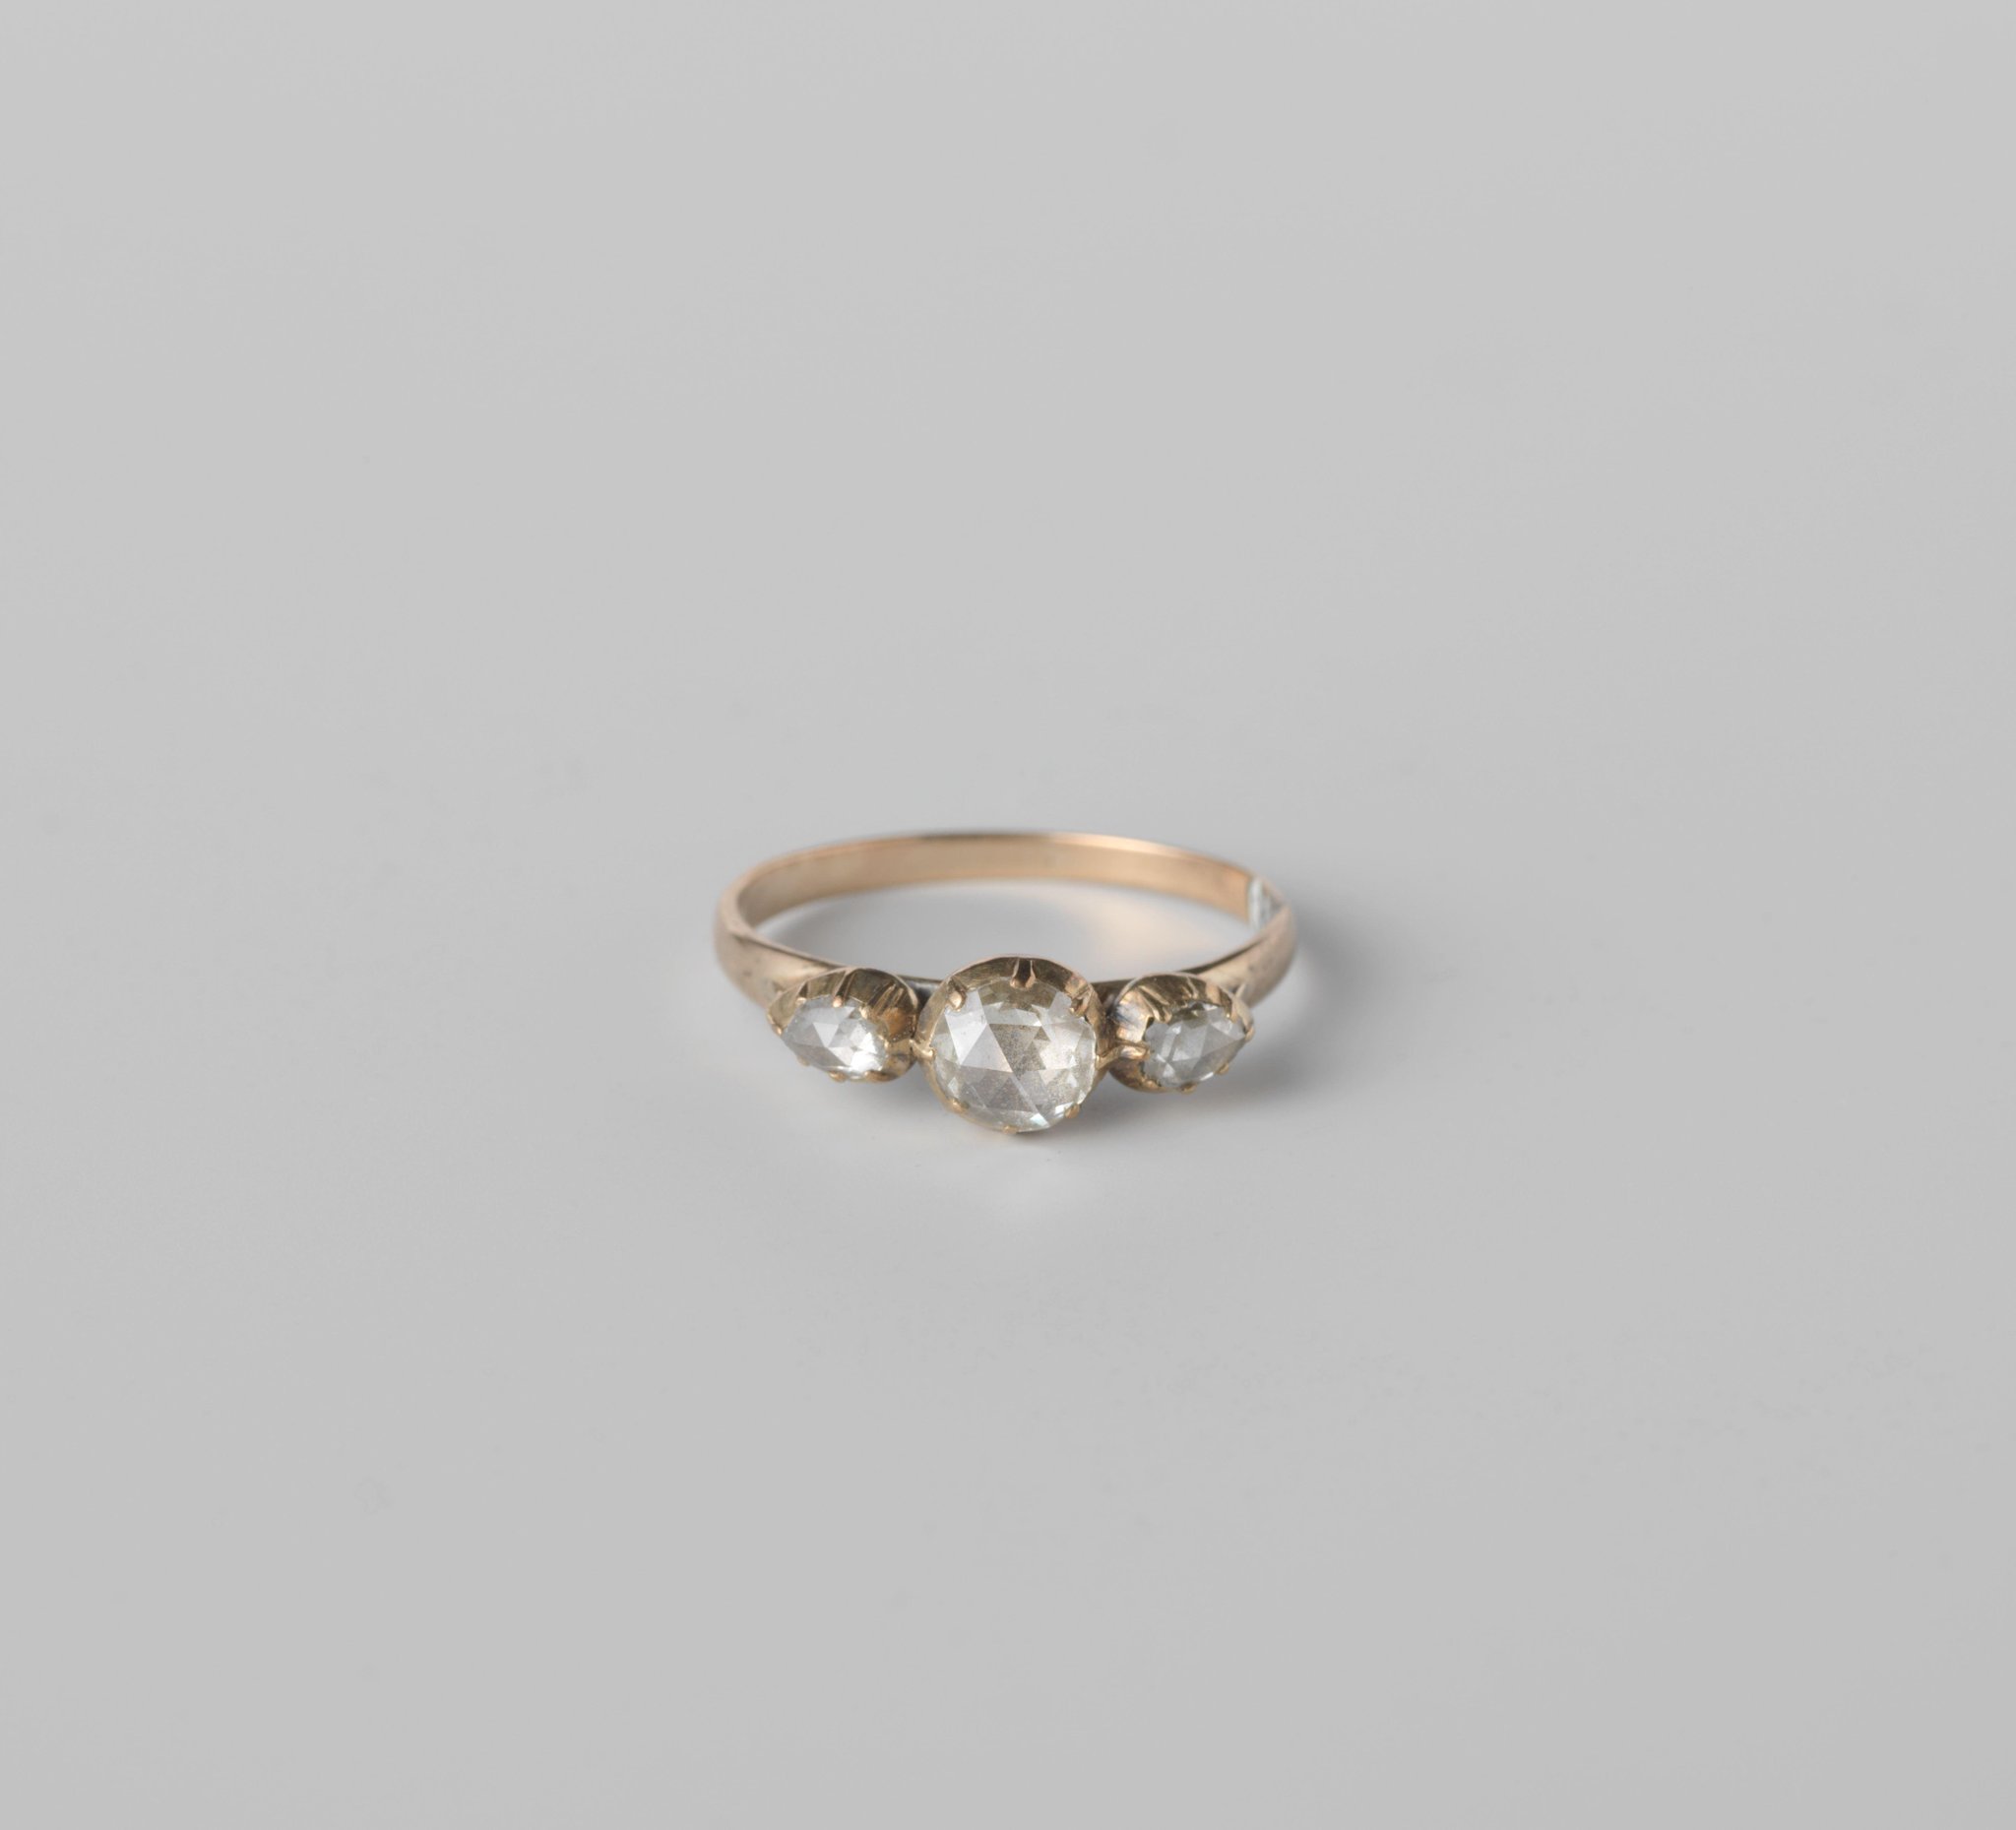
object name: ring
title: Ring met diamanten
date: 1800-1900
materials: diamond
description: Ring met drie roosdiamanten. Eén grote ronde diamant tussen twee enigszins ovalen.